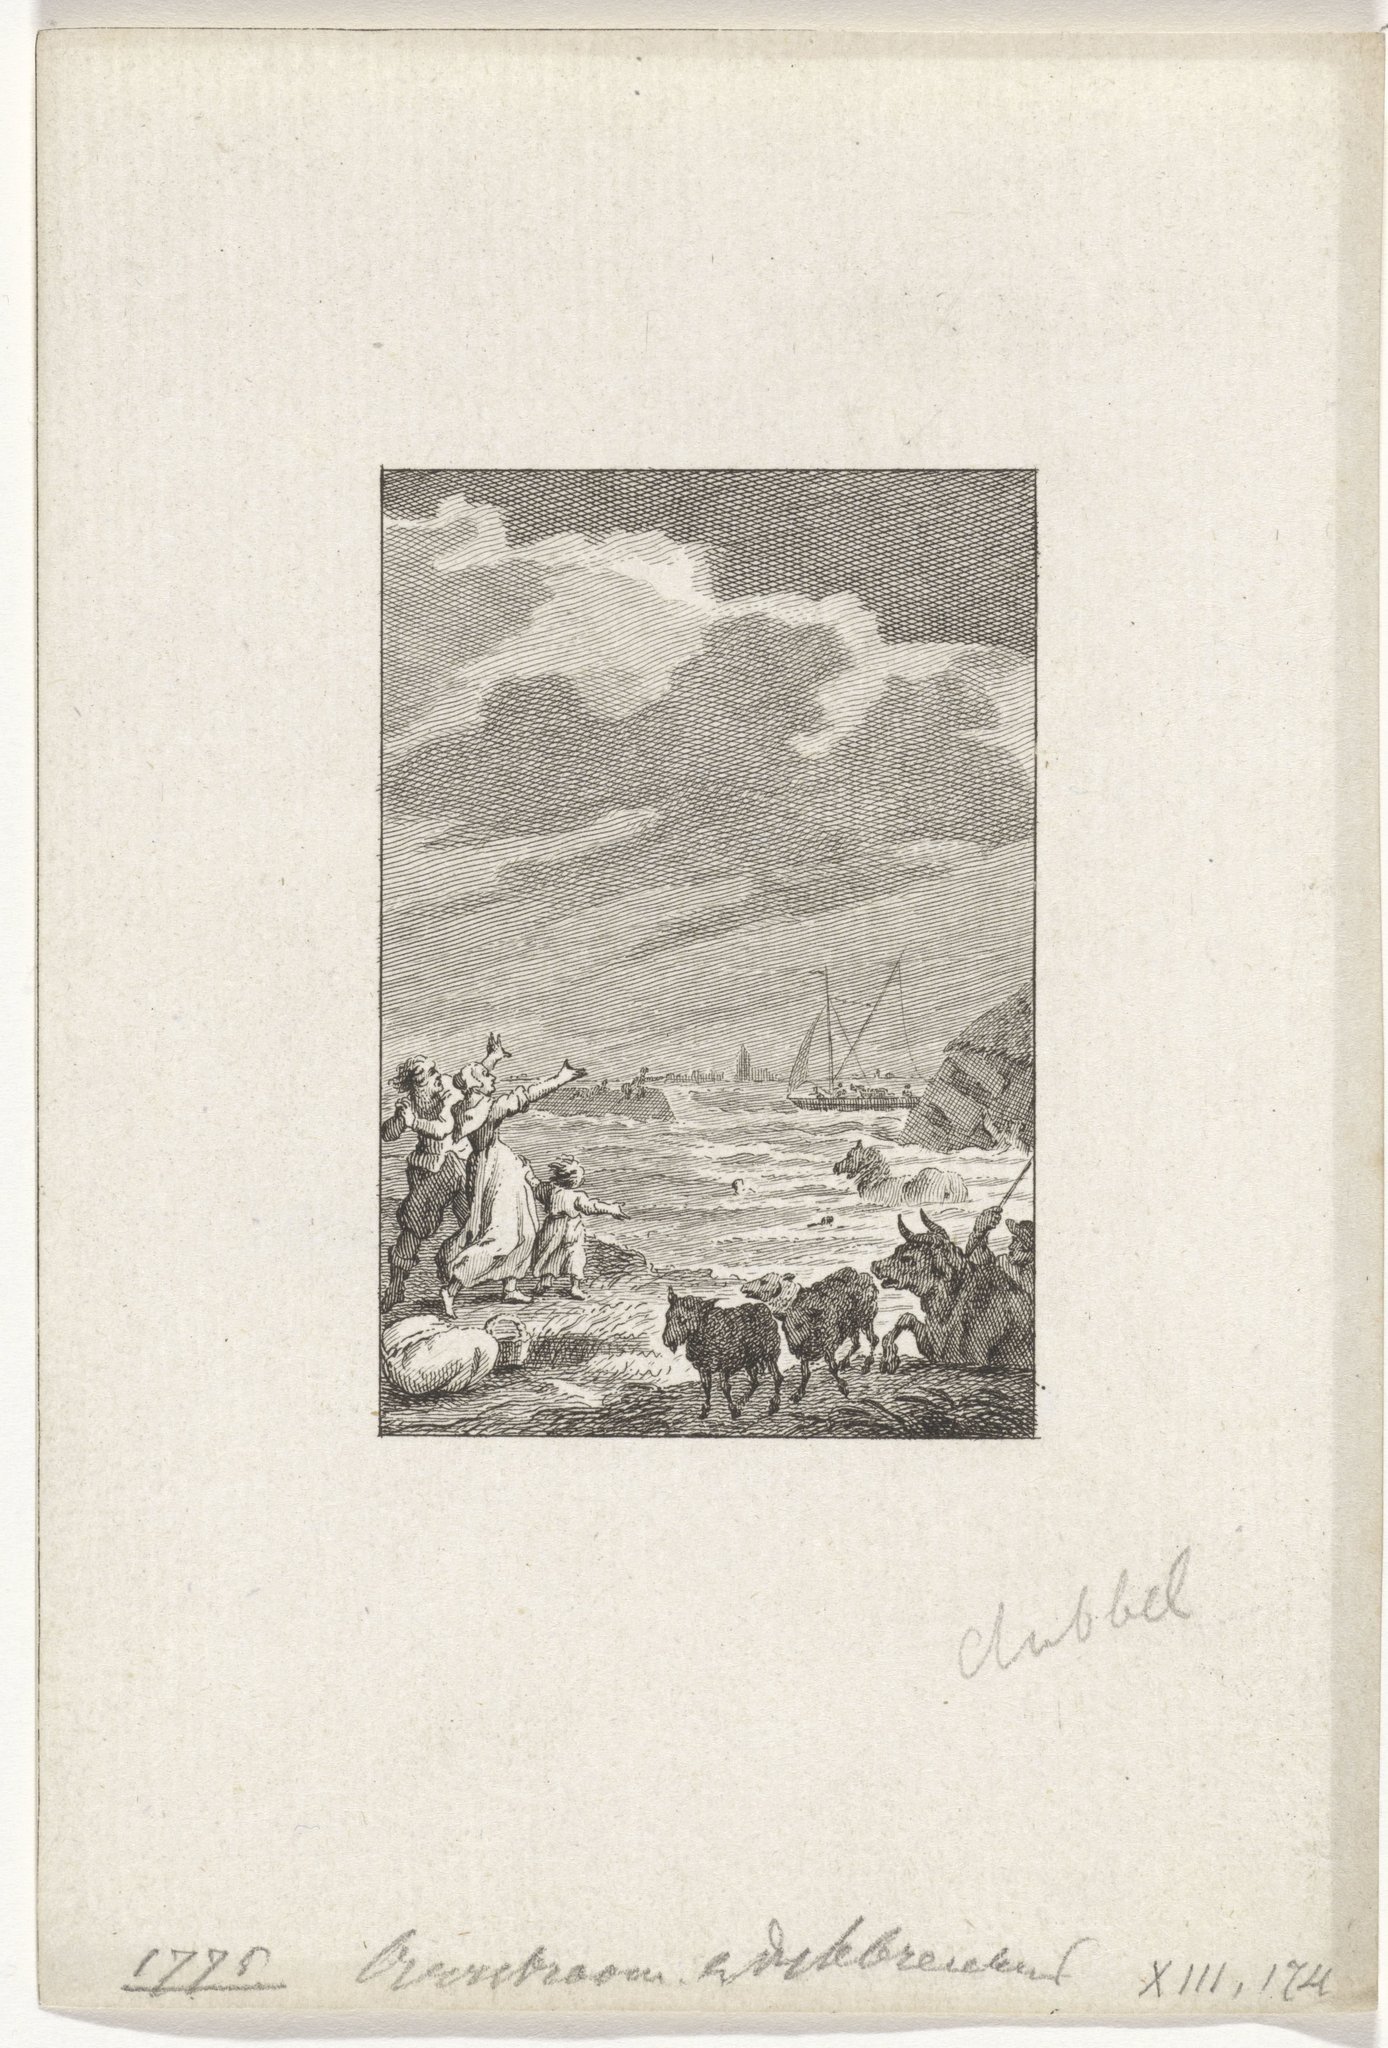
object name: print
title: Watersnood van 1775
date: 1783-1795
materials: paper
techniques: etching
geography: amsterdam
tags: dike-break, the flood of 14-18 november 1775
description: Illustratie voor: J. Fokke. Geschiedenissen der Vereenigde Nederlanden voor de vaderlandsche jeugd. Amsterdam: Johannes Allart, 1783-1795, 25 delen. deel XIII.